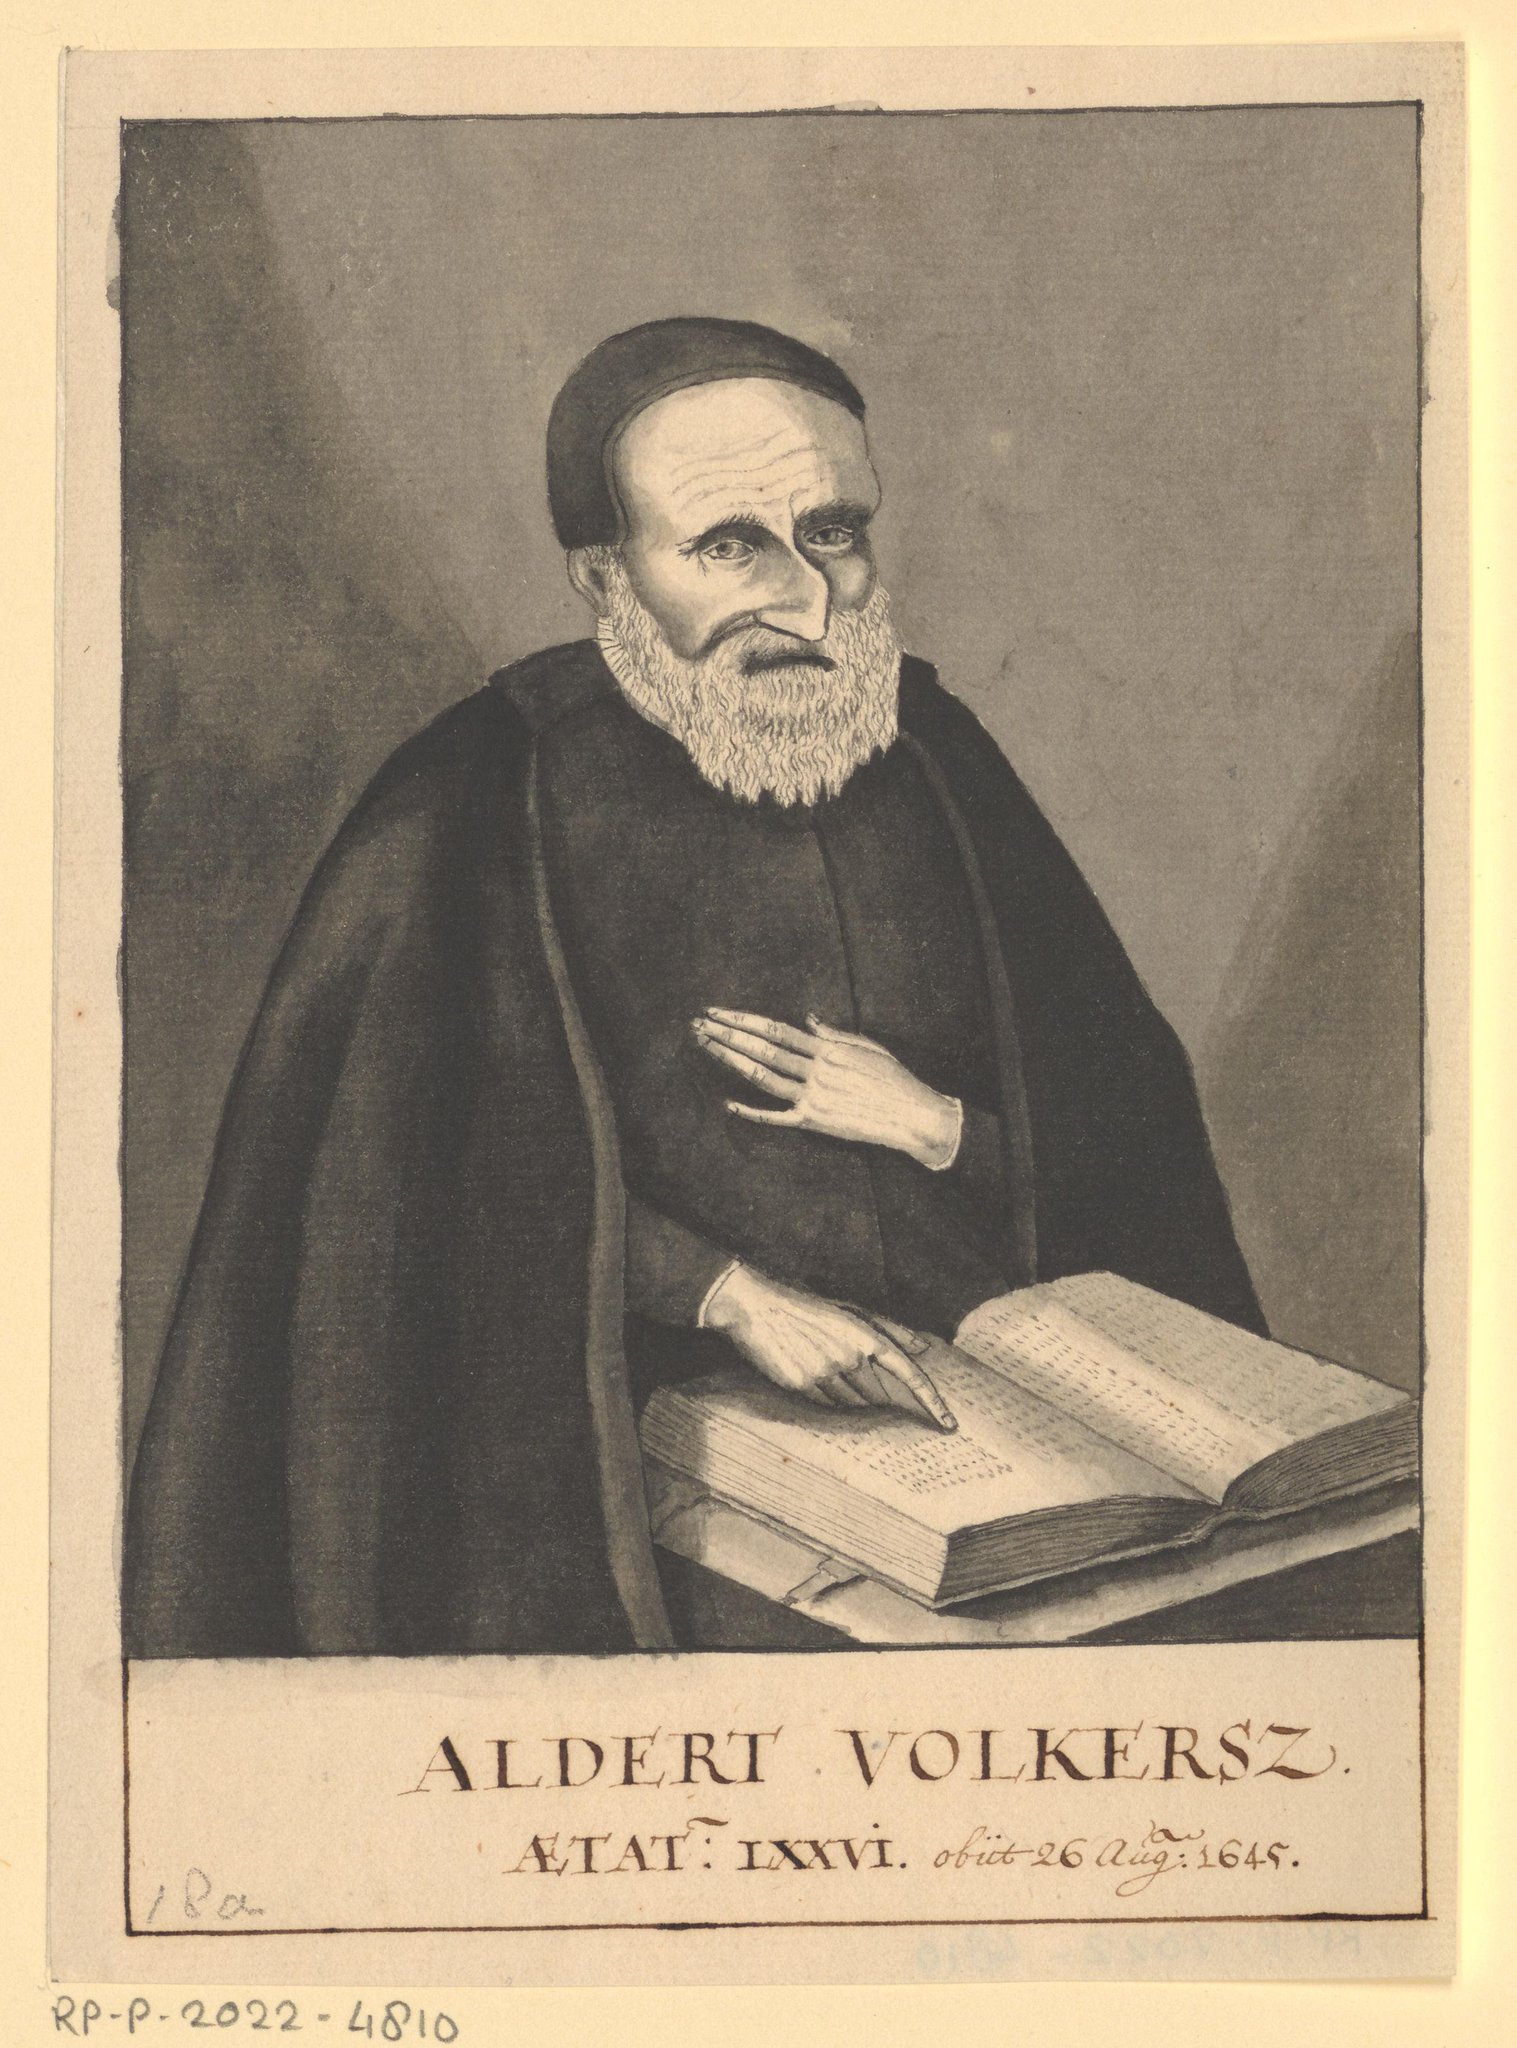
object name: drawing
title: Portret van Aldert Volkerts op 76-jarige leeftijd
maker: Anonymous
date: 1645-1800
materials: paper, watercolor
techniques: brush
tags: theologian, historical persons